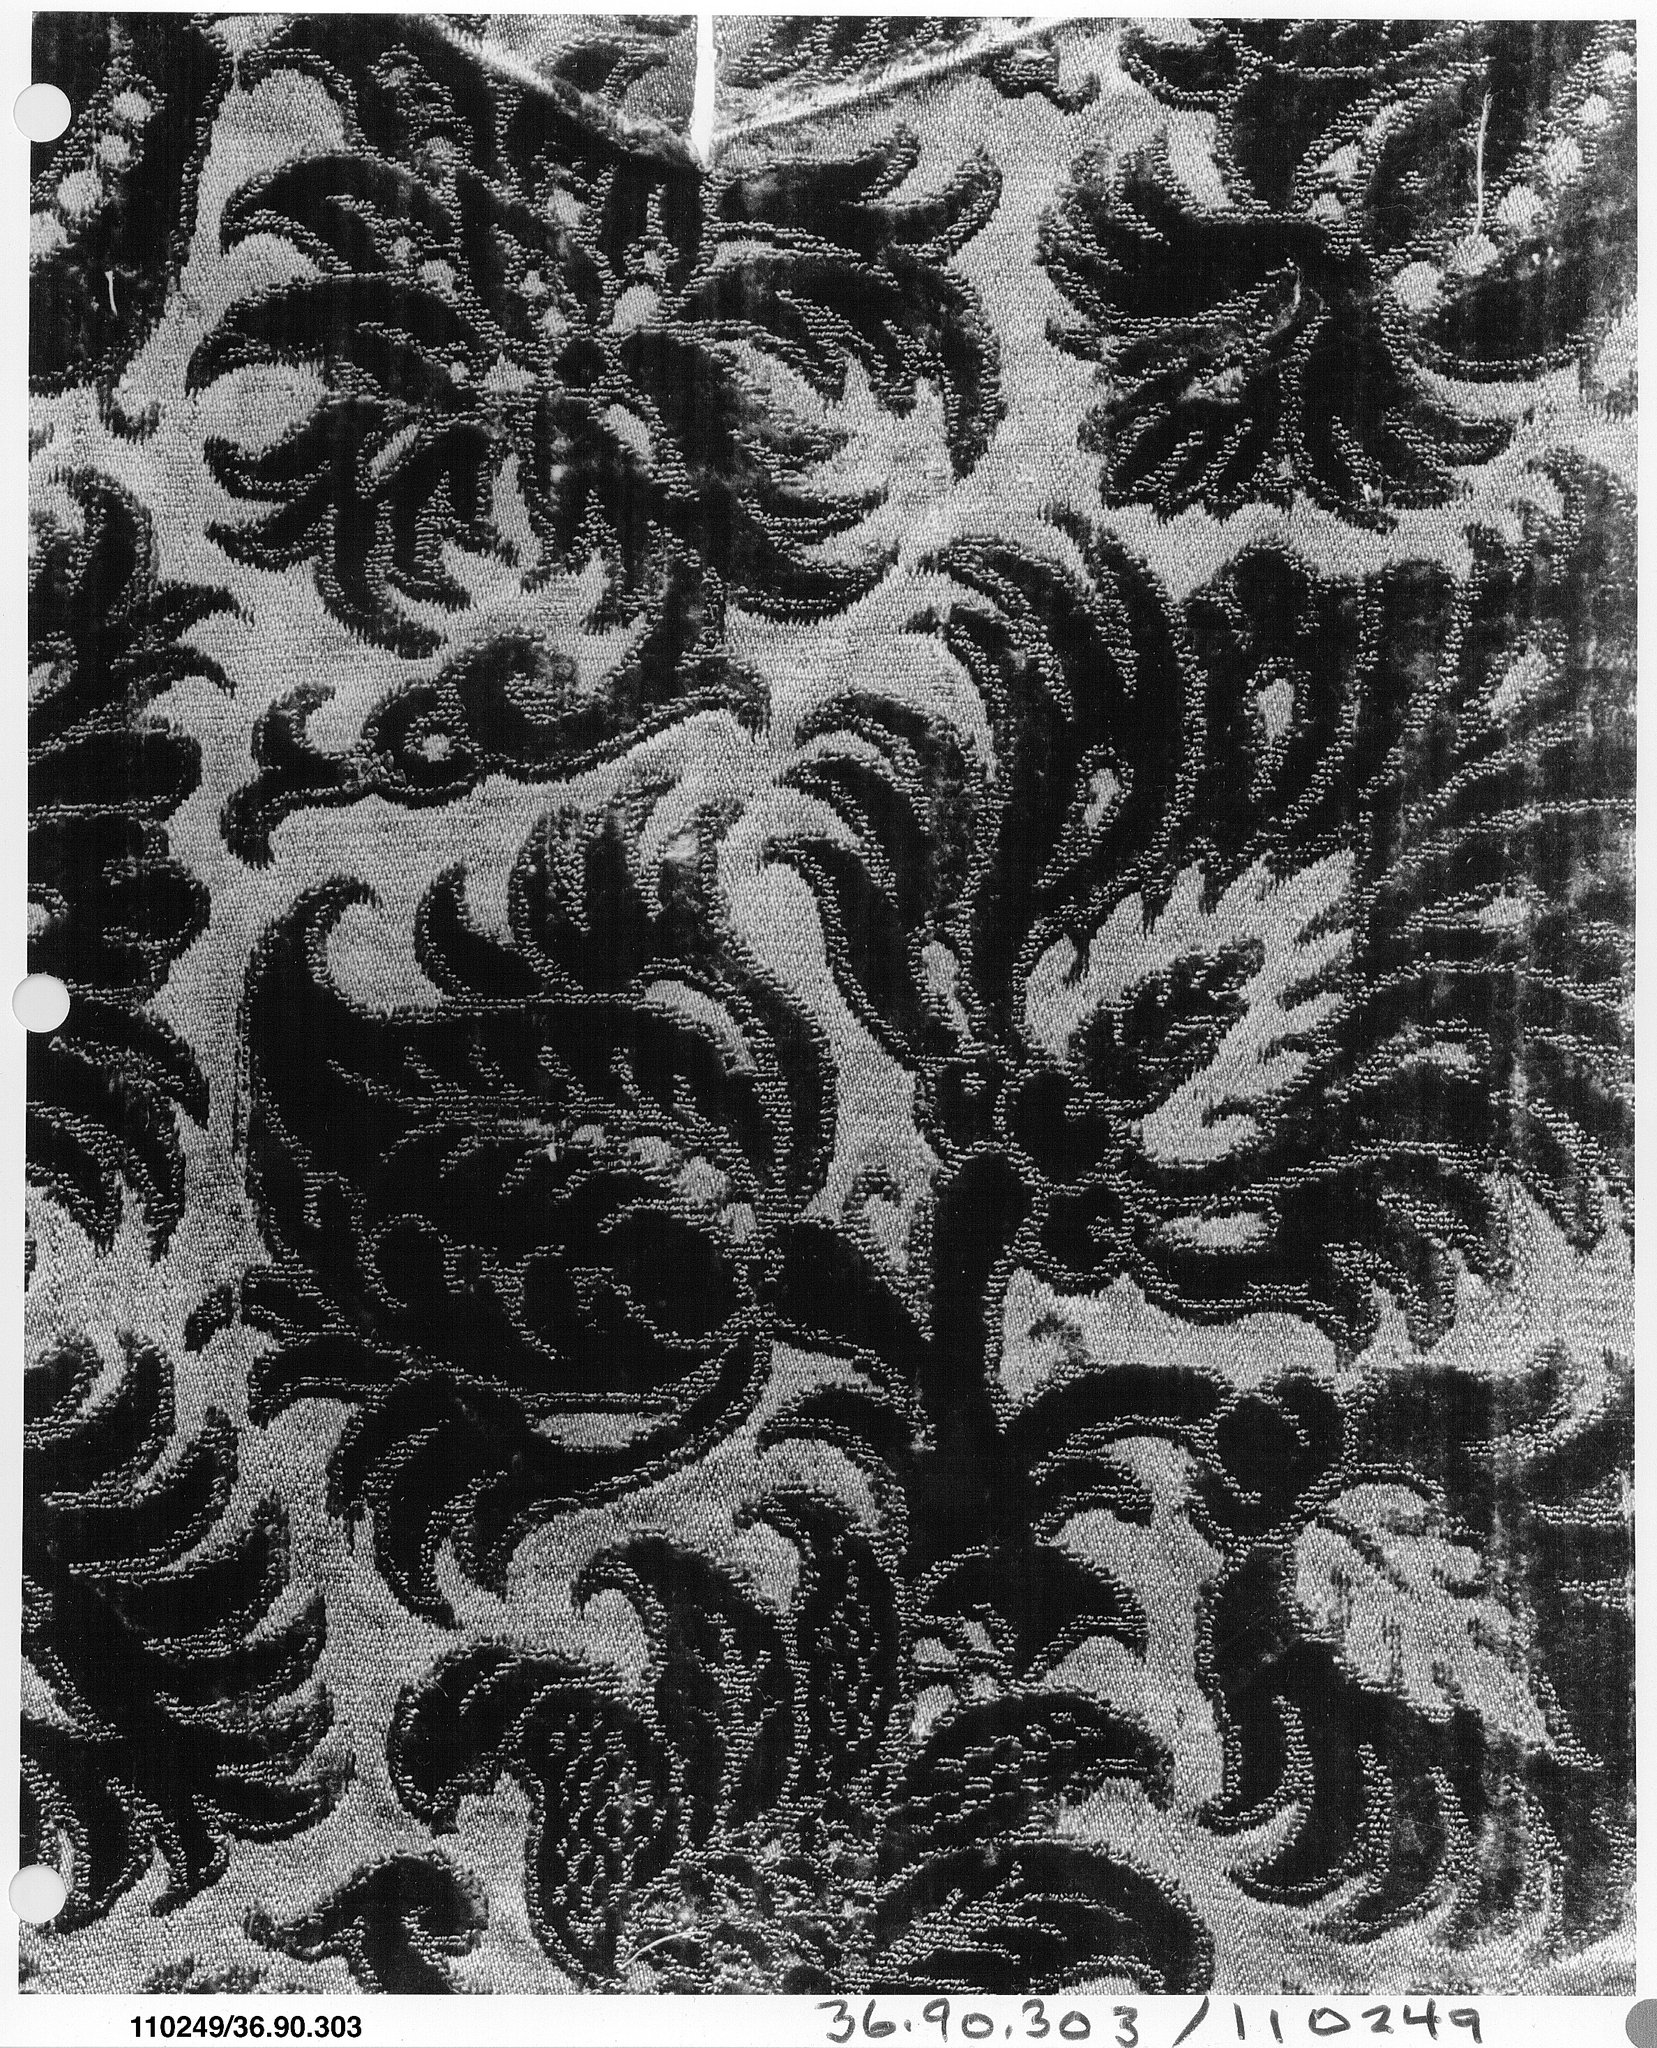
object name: piece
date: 1501-1700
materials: silk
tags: leaves